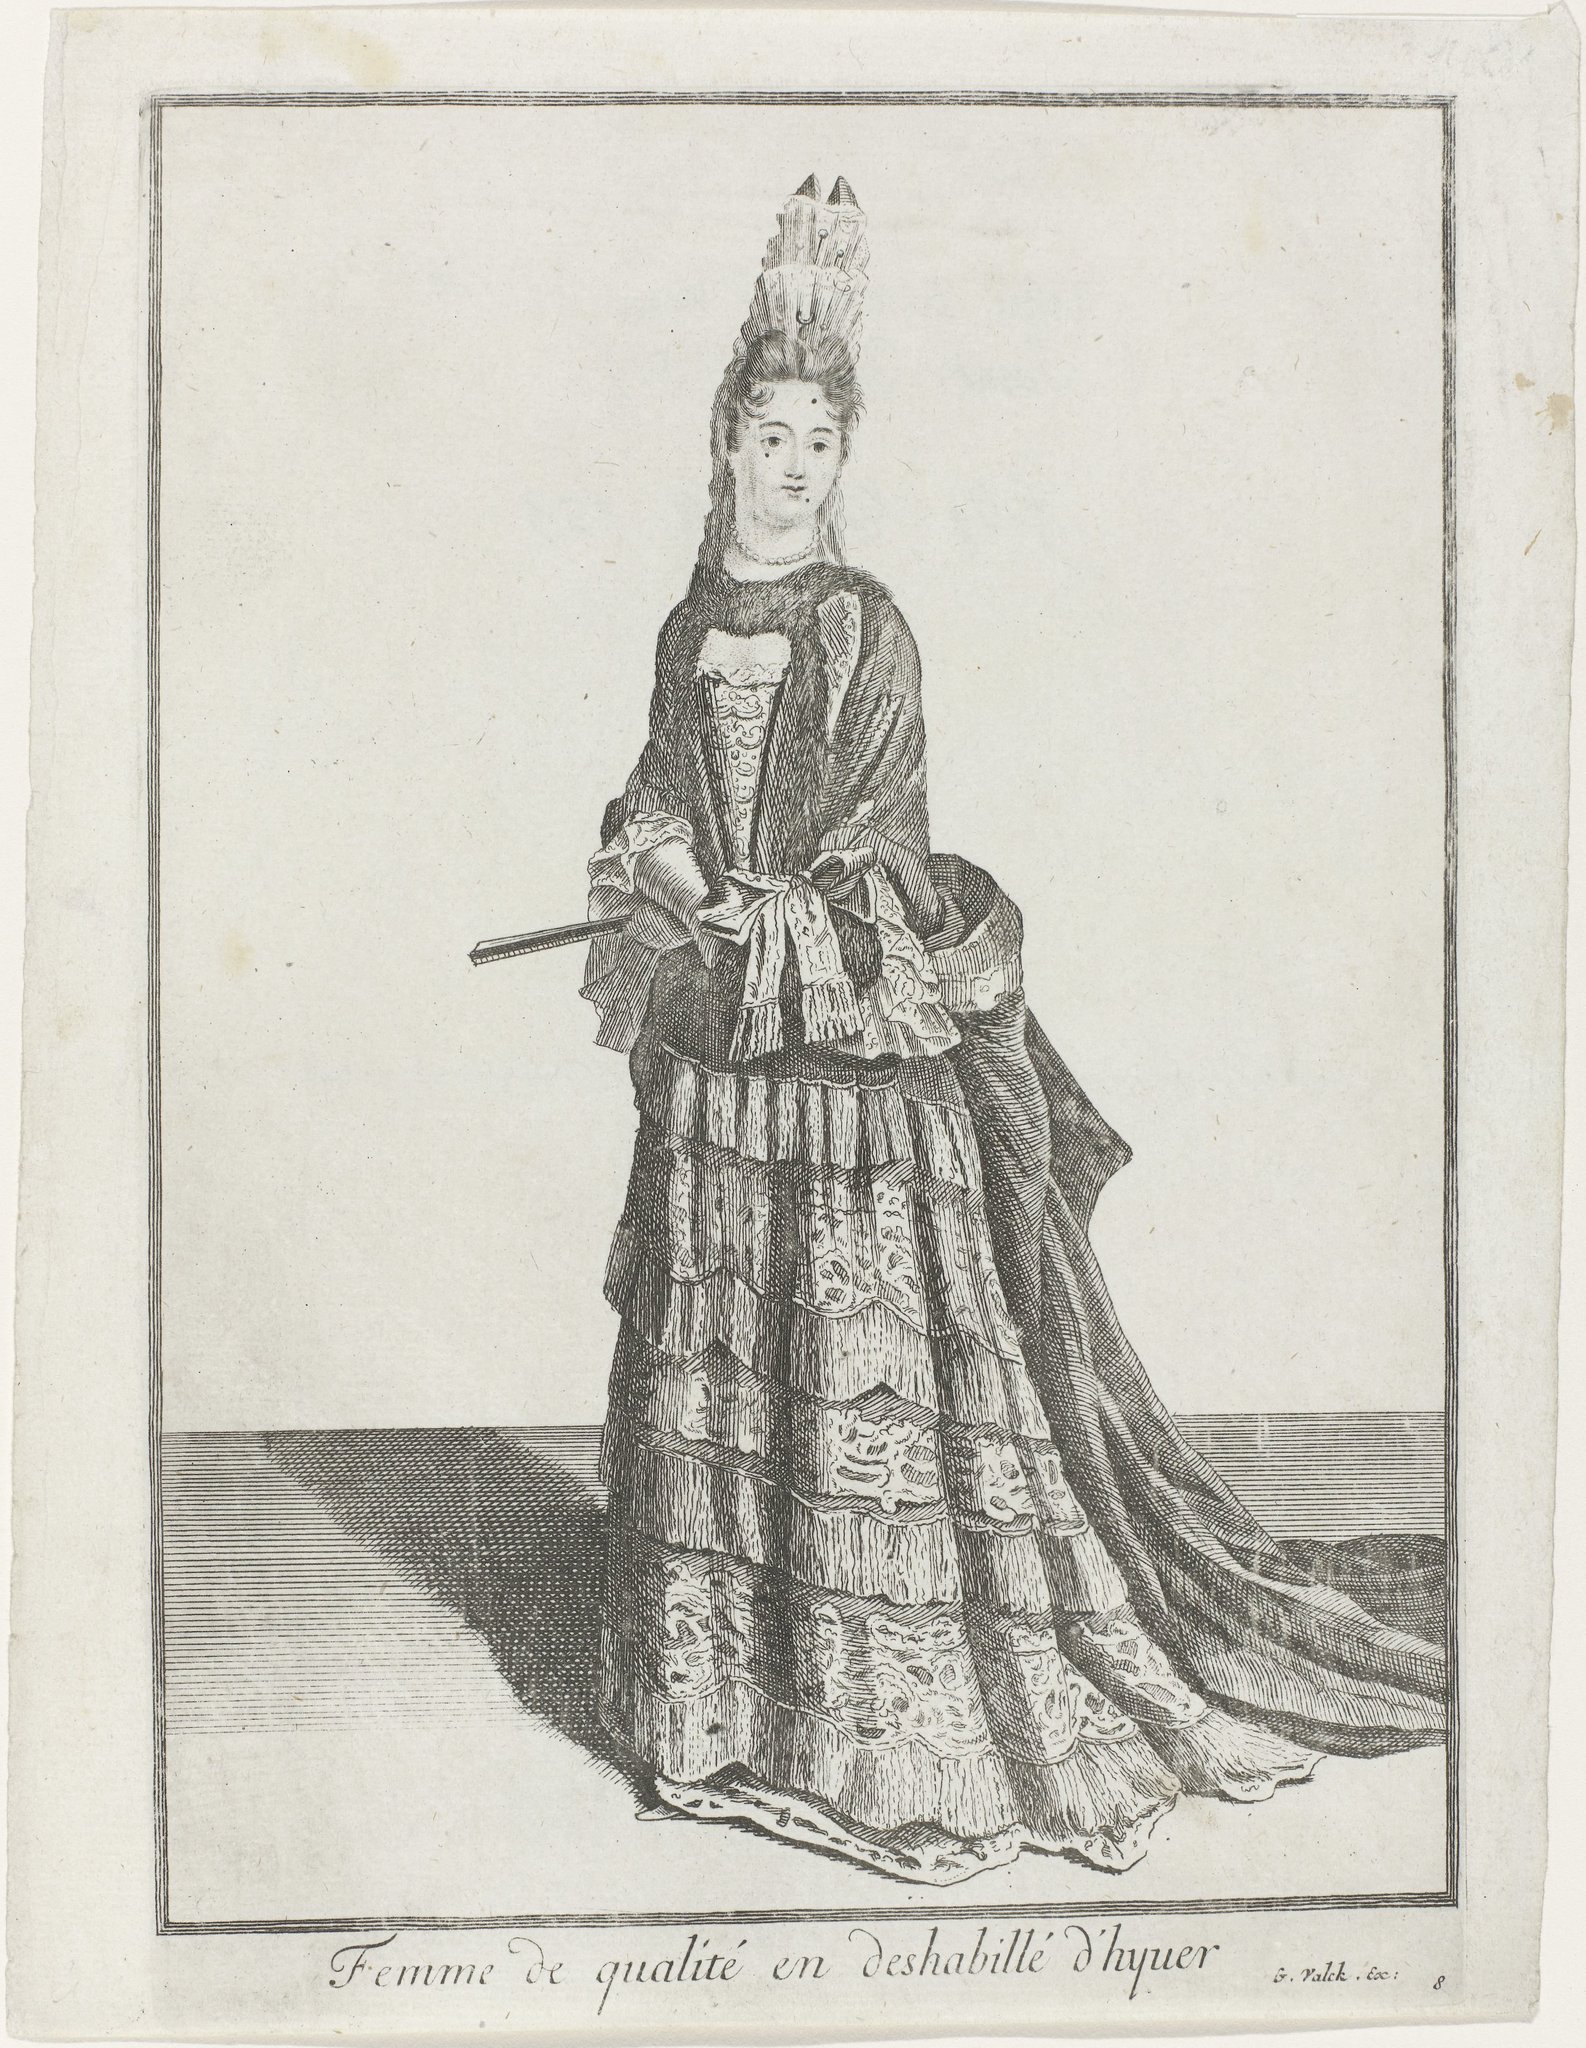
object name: costume print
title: Vooraanstaande vrouw in winterkleren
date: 1680-1720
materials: paper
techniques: engraving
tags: clothing for the upper part of the body (+ women's clothes), piece of clothing covering the breast or décolleté (stomacher) (+ women's clothes), neck-gear ~ clothing (palatine) (+ women's clothes), neck-gear ~ clothing (palatine) (+ feathers used for clothes), fashion plates, skirt (+ women's clothes), head-gear: fontange (+ women's clothes), dress, gown: manteau (+ women's clothes), muff (+ fur used for clothes), pearl; pearl necklace (+ women's clothes)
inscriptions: title: ‘Femme de qualité en deshabillé d'hyver’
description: Dame met fontangekapsel. Zij draagt een manteau met sleep, een smalle bontstola (palatine) en een rok met falbala's. Op het gezicht drie mouches. Vouwwaaier met strik in de linkerhand. Andere accessoires: een kralencollier (parelcollier), een mof van bont, engageantes en handschoenen.